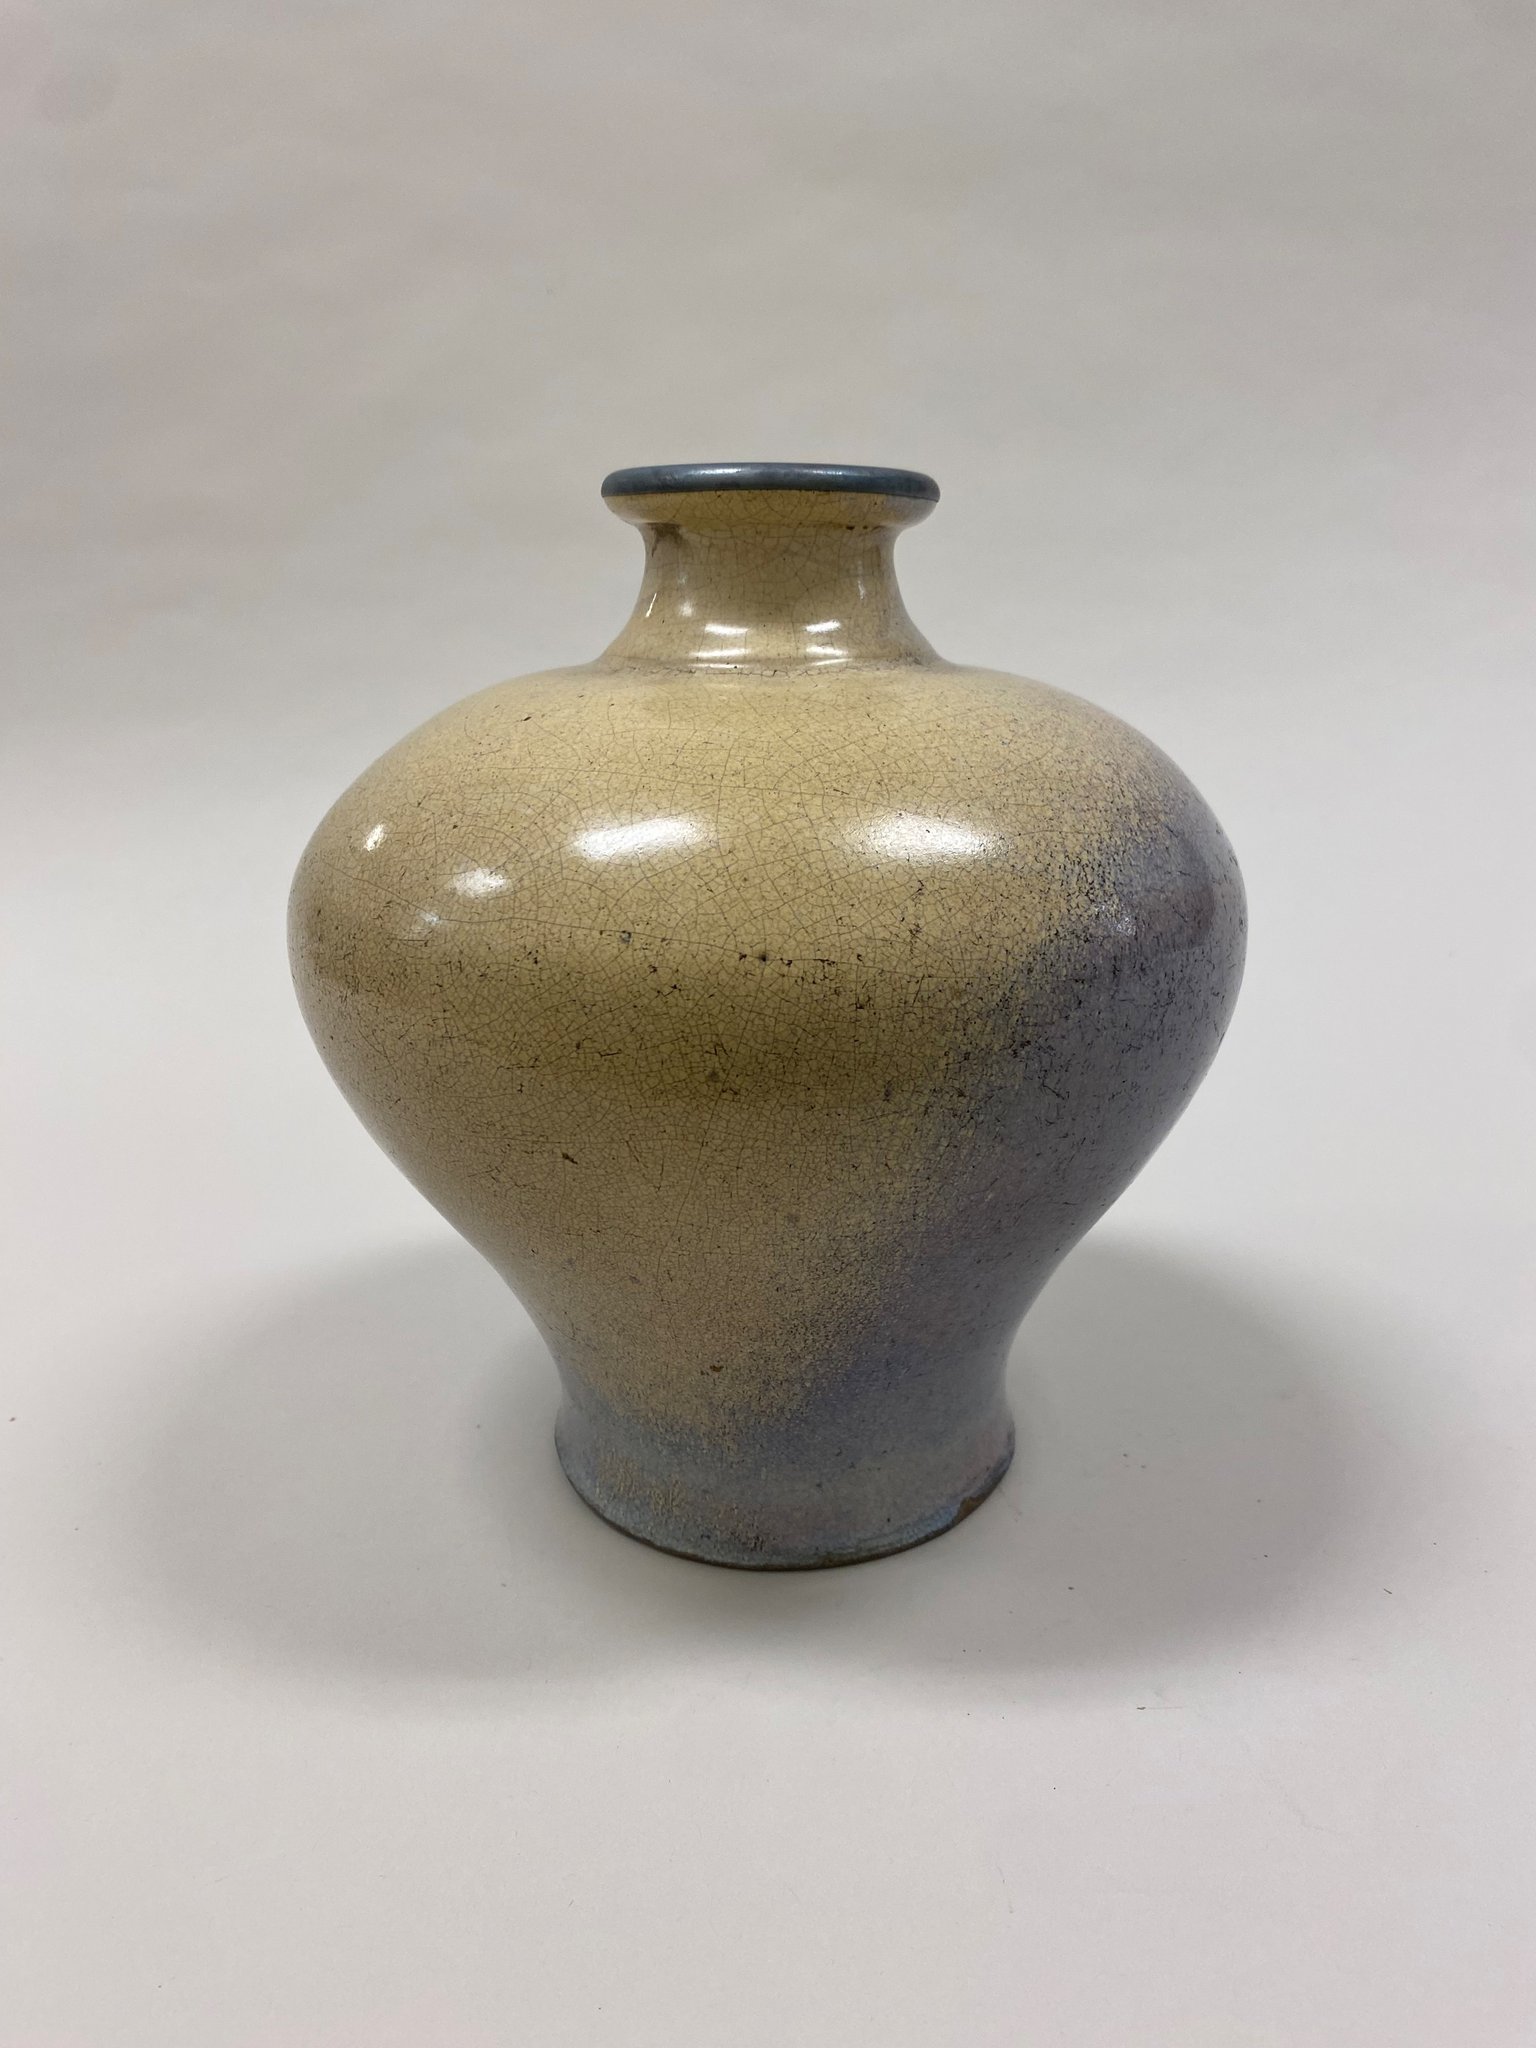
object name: bottle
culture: chinese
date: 1801-1900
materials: glaze, stoneware